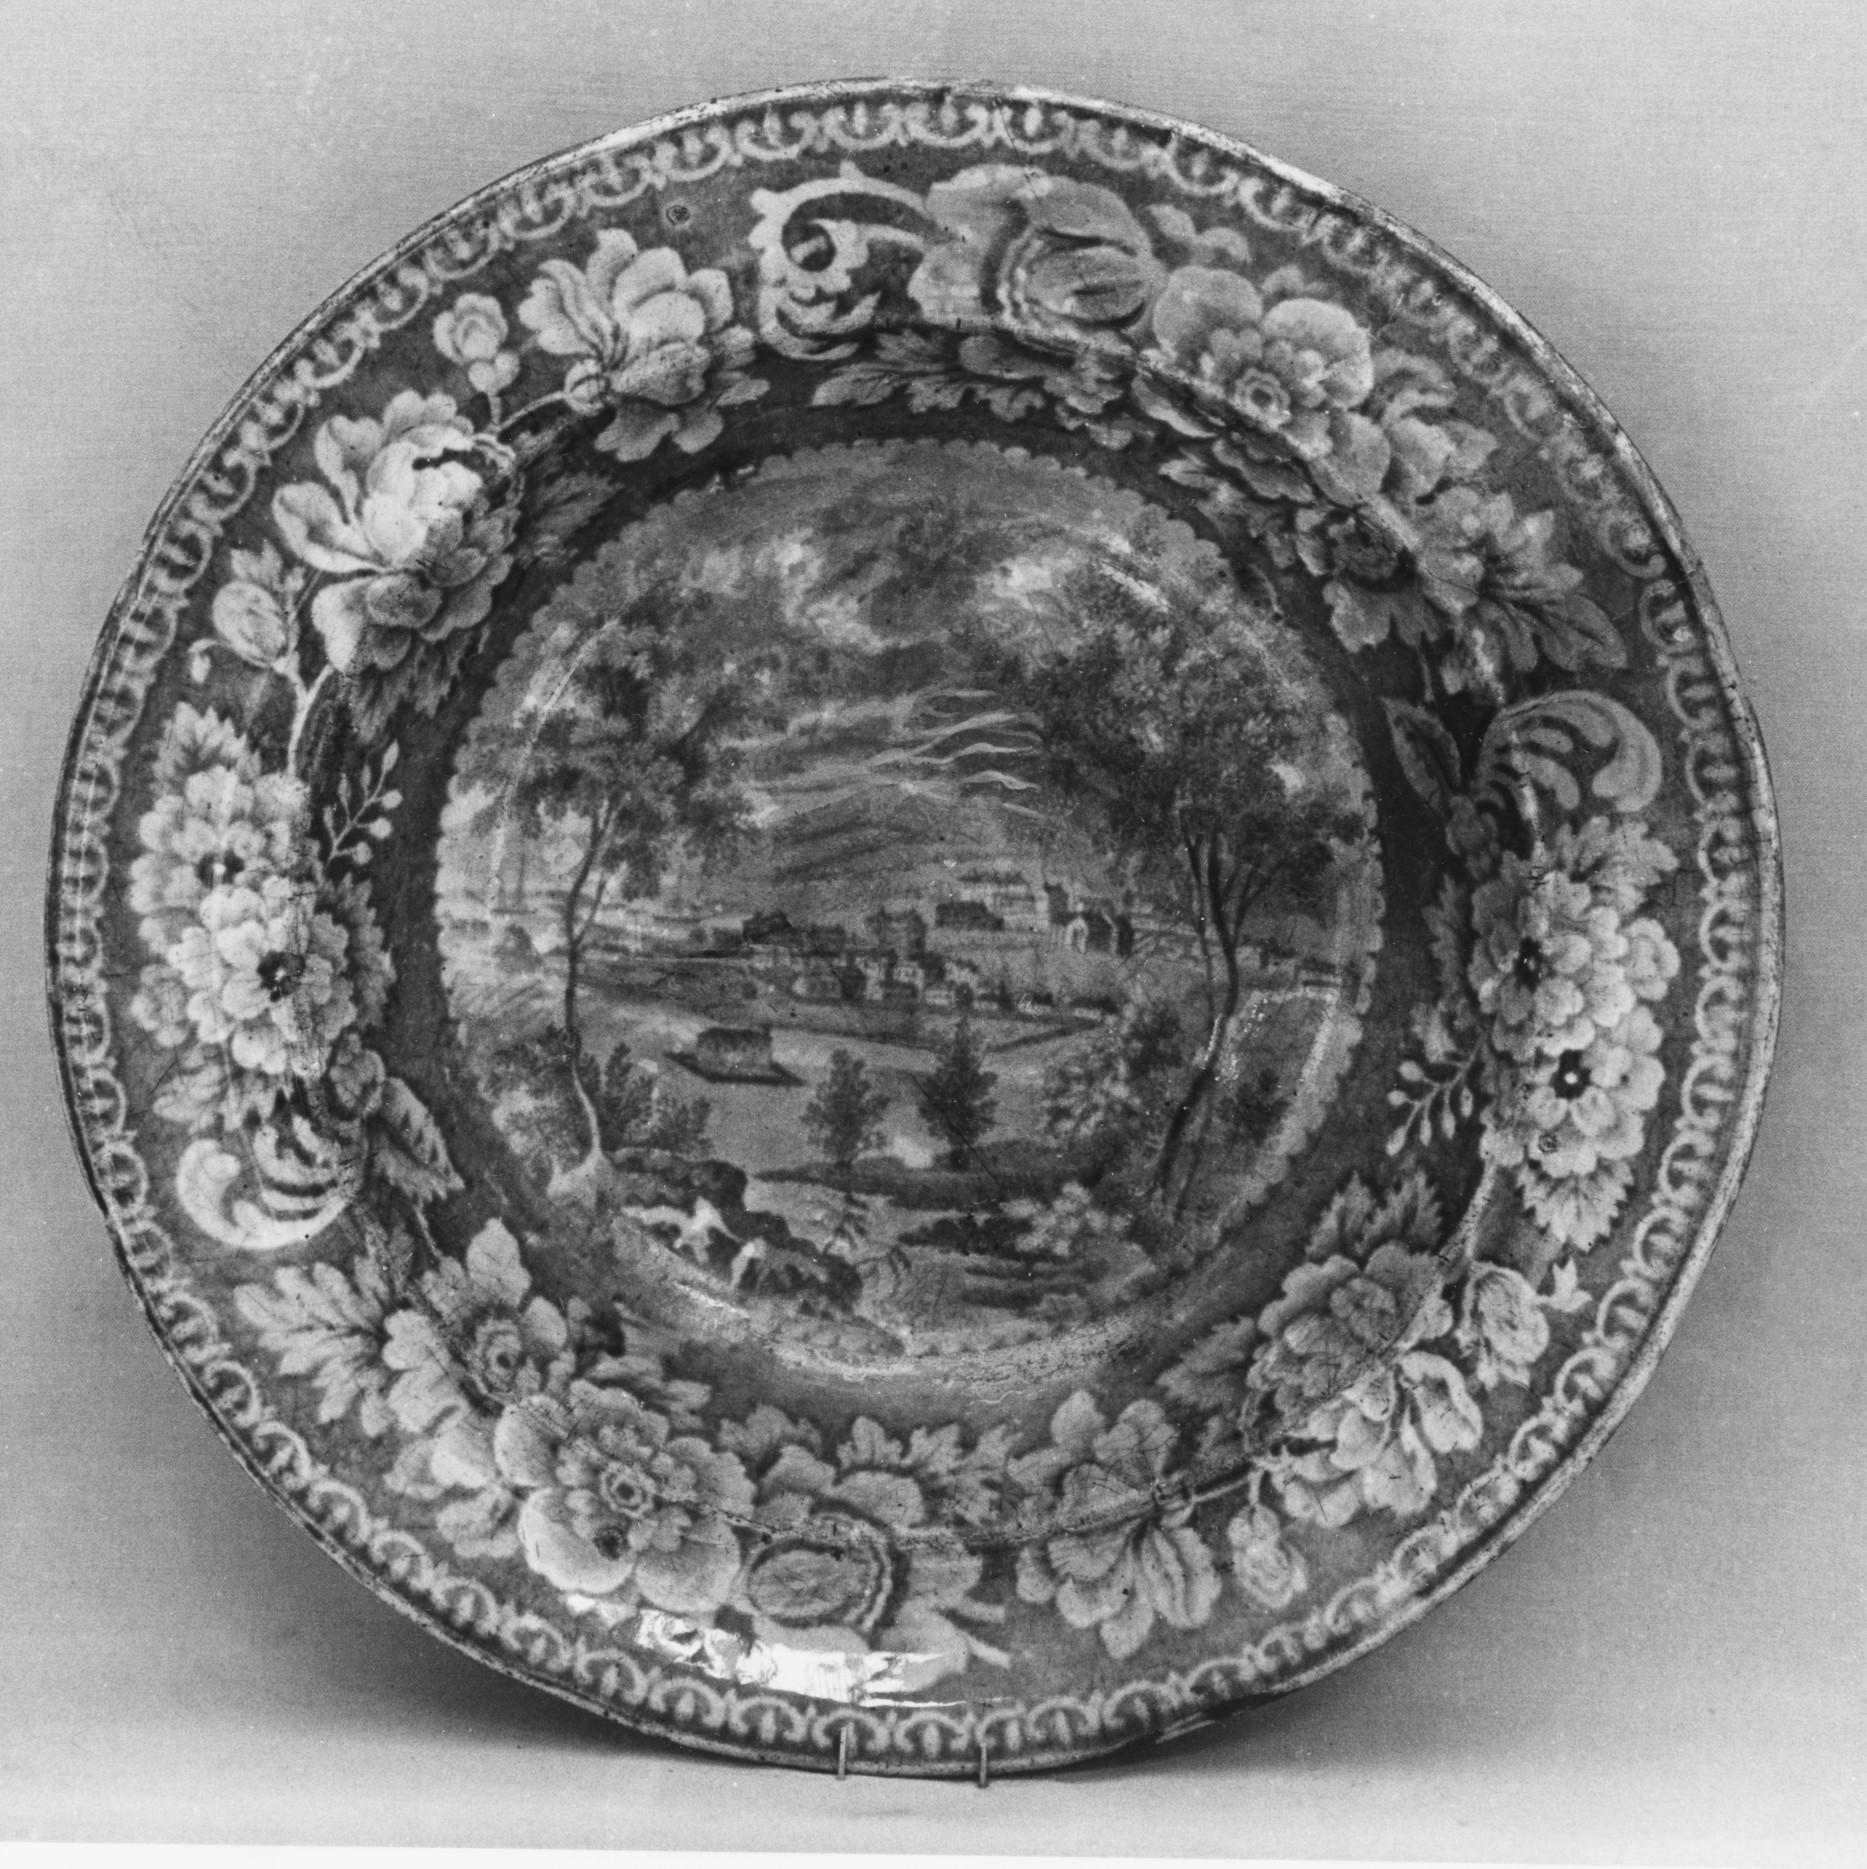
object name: plate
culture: british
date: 1805-1825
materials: earthenware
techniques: transfer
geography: england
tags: flowers,landscapes